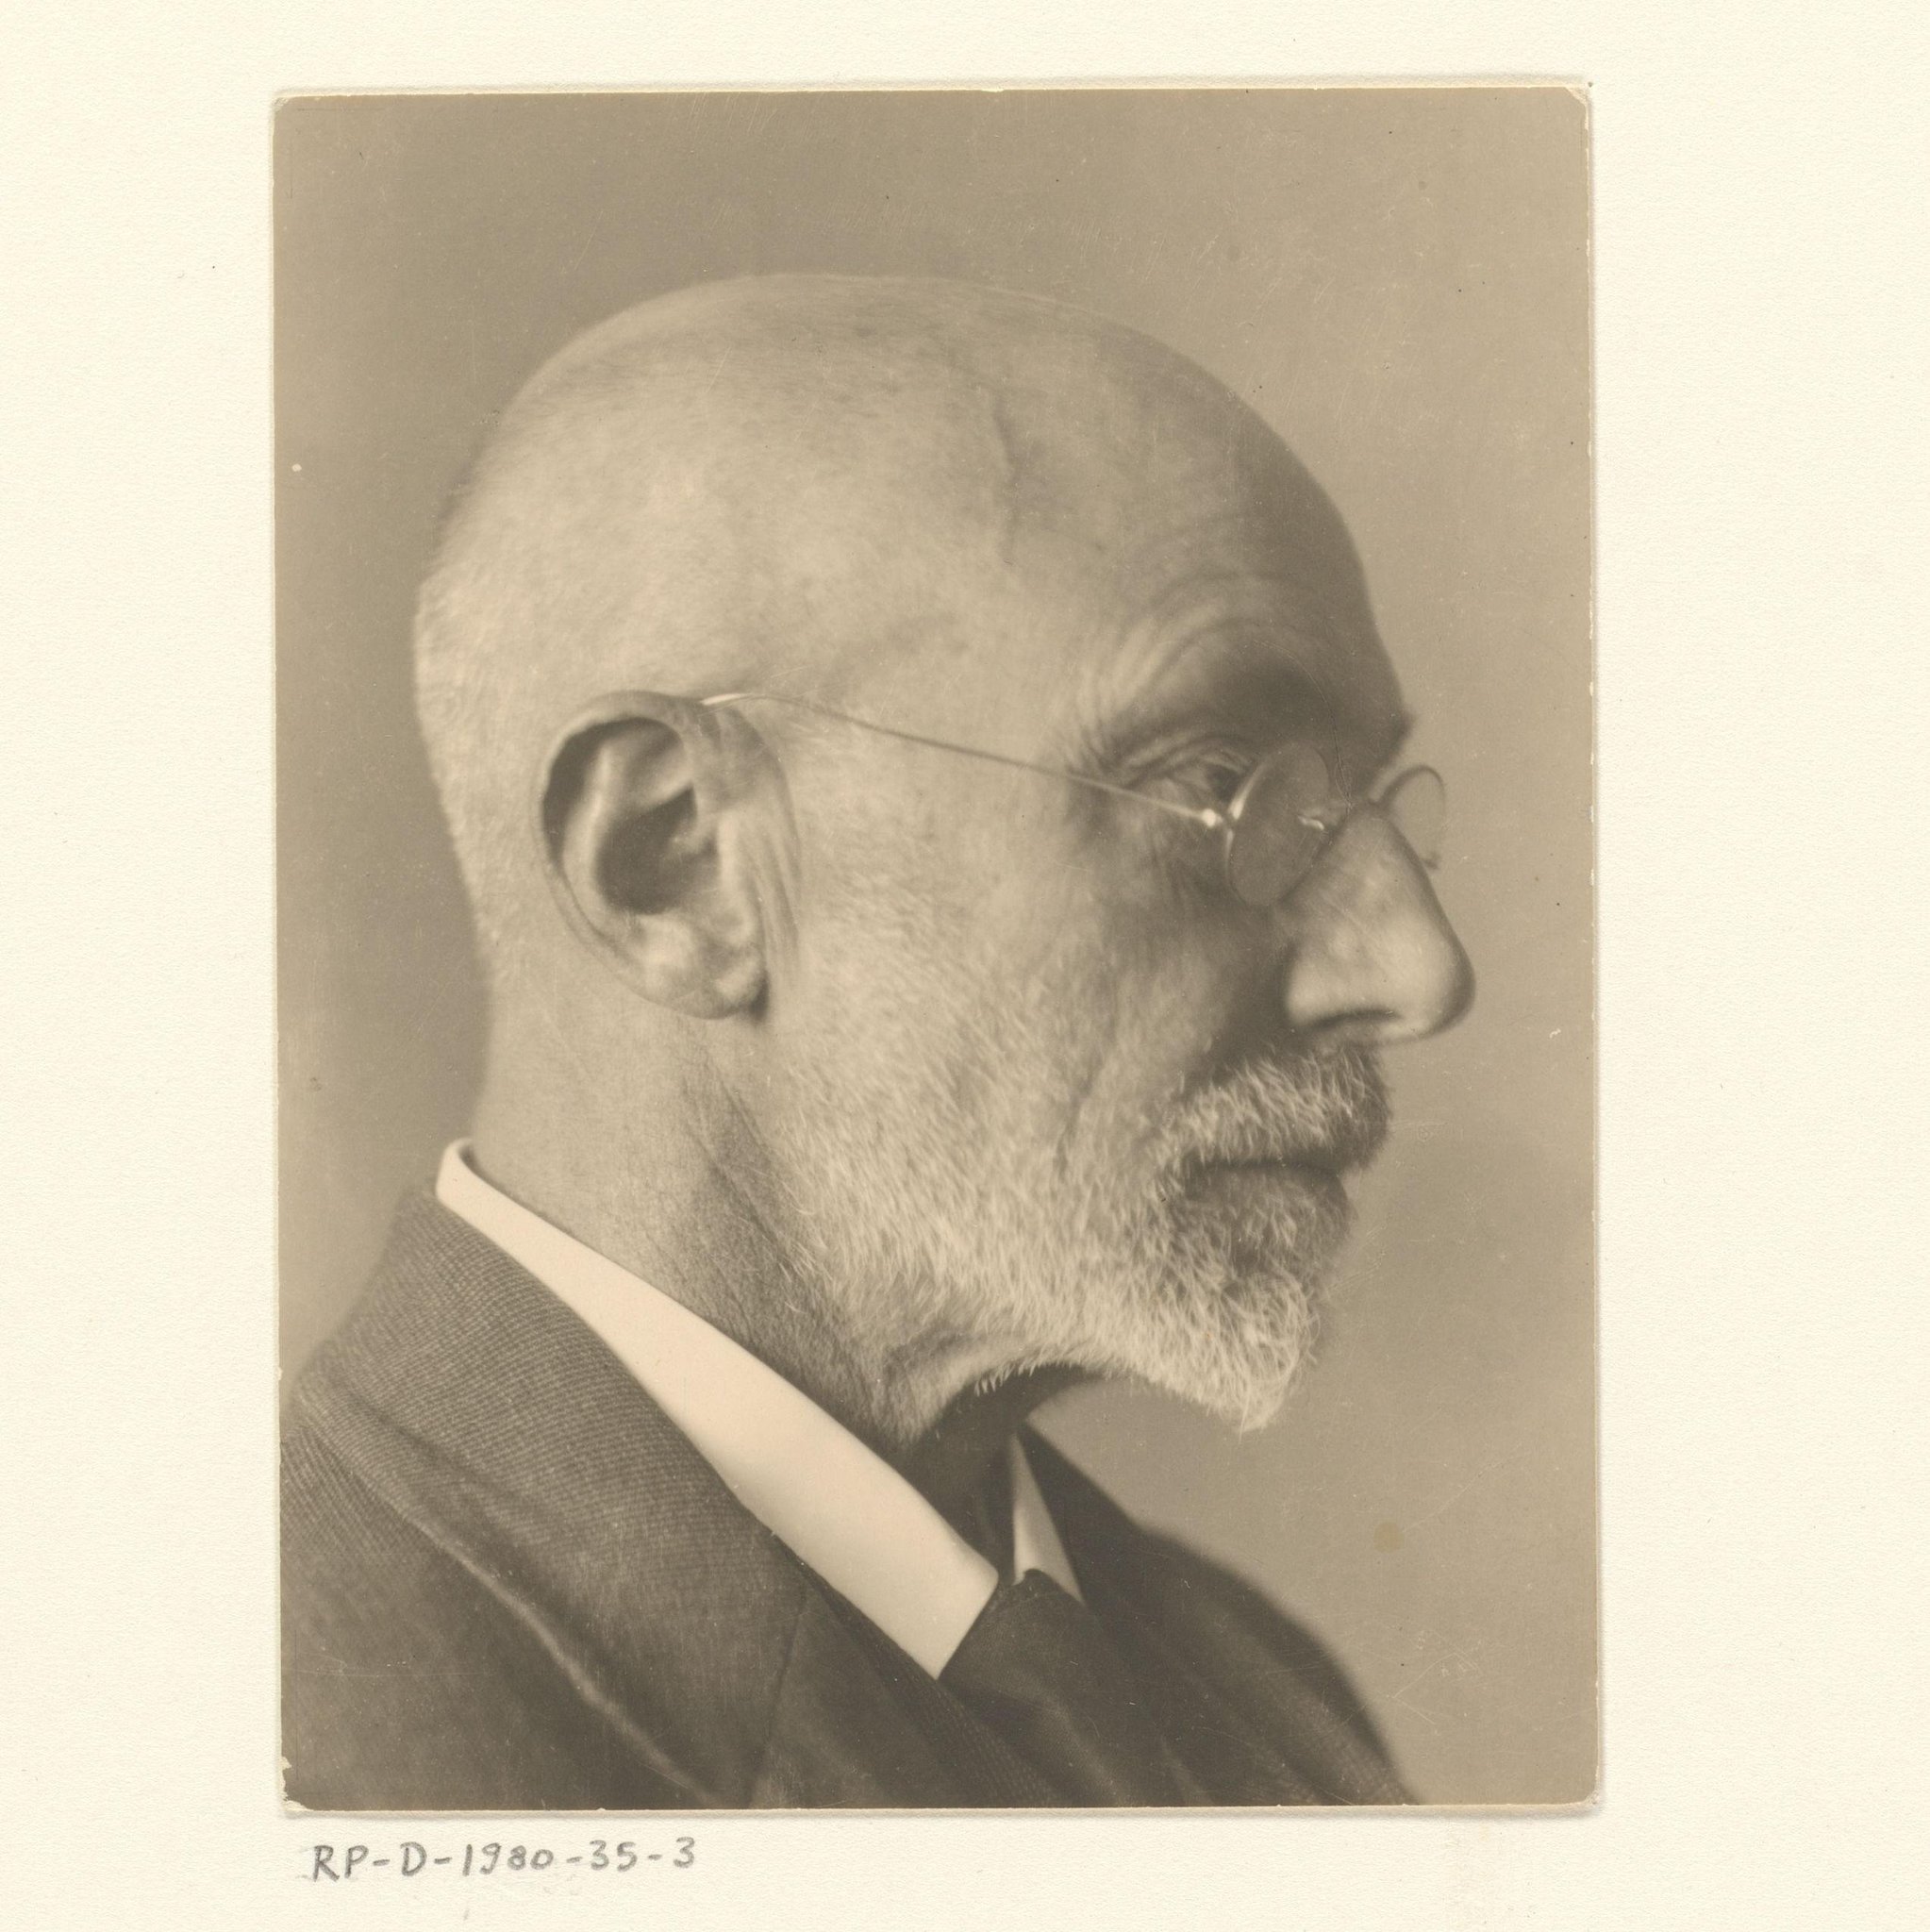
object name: photograph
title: Portret van Maurits van der Valk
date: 1910-1930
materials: paper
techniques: gelatin silver print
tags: print maker, draughtsman, maurits van der valk, historical persons, portrait, self-portrait of graphic artist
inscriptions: collector's mark: Lugt 2228a, inscription: ‘M vd Valk’